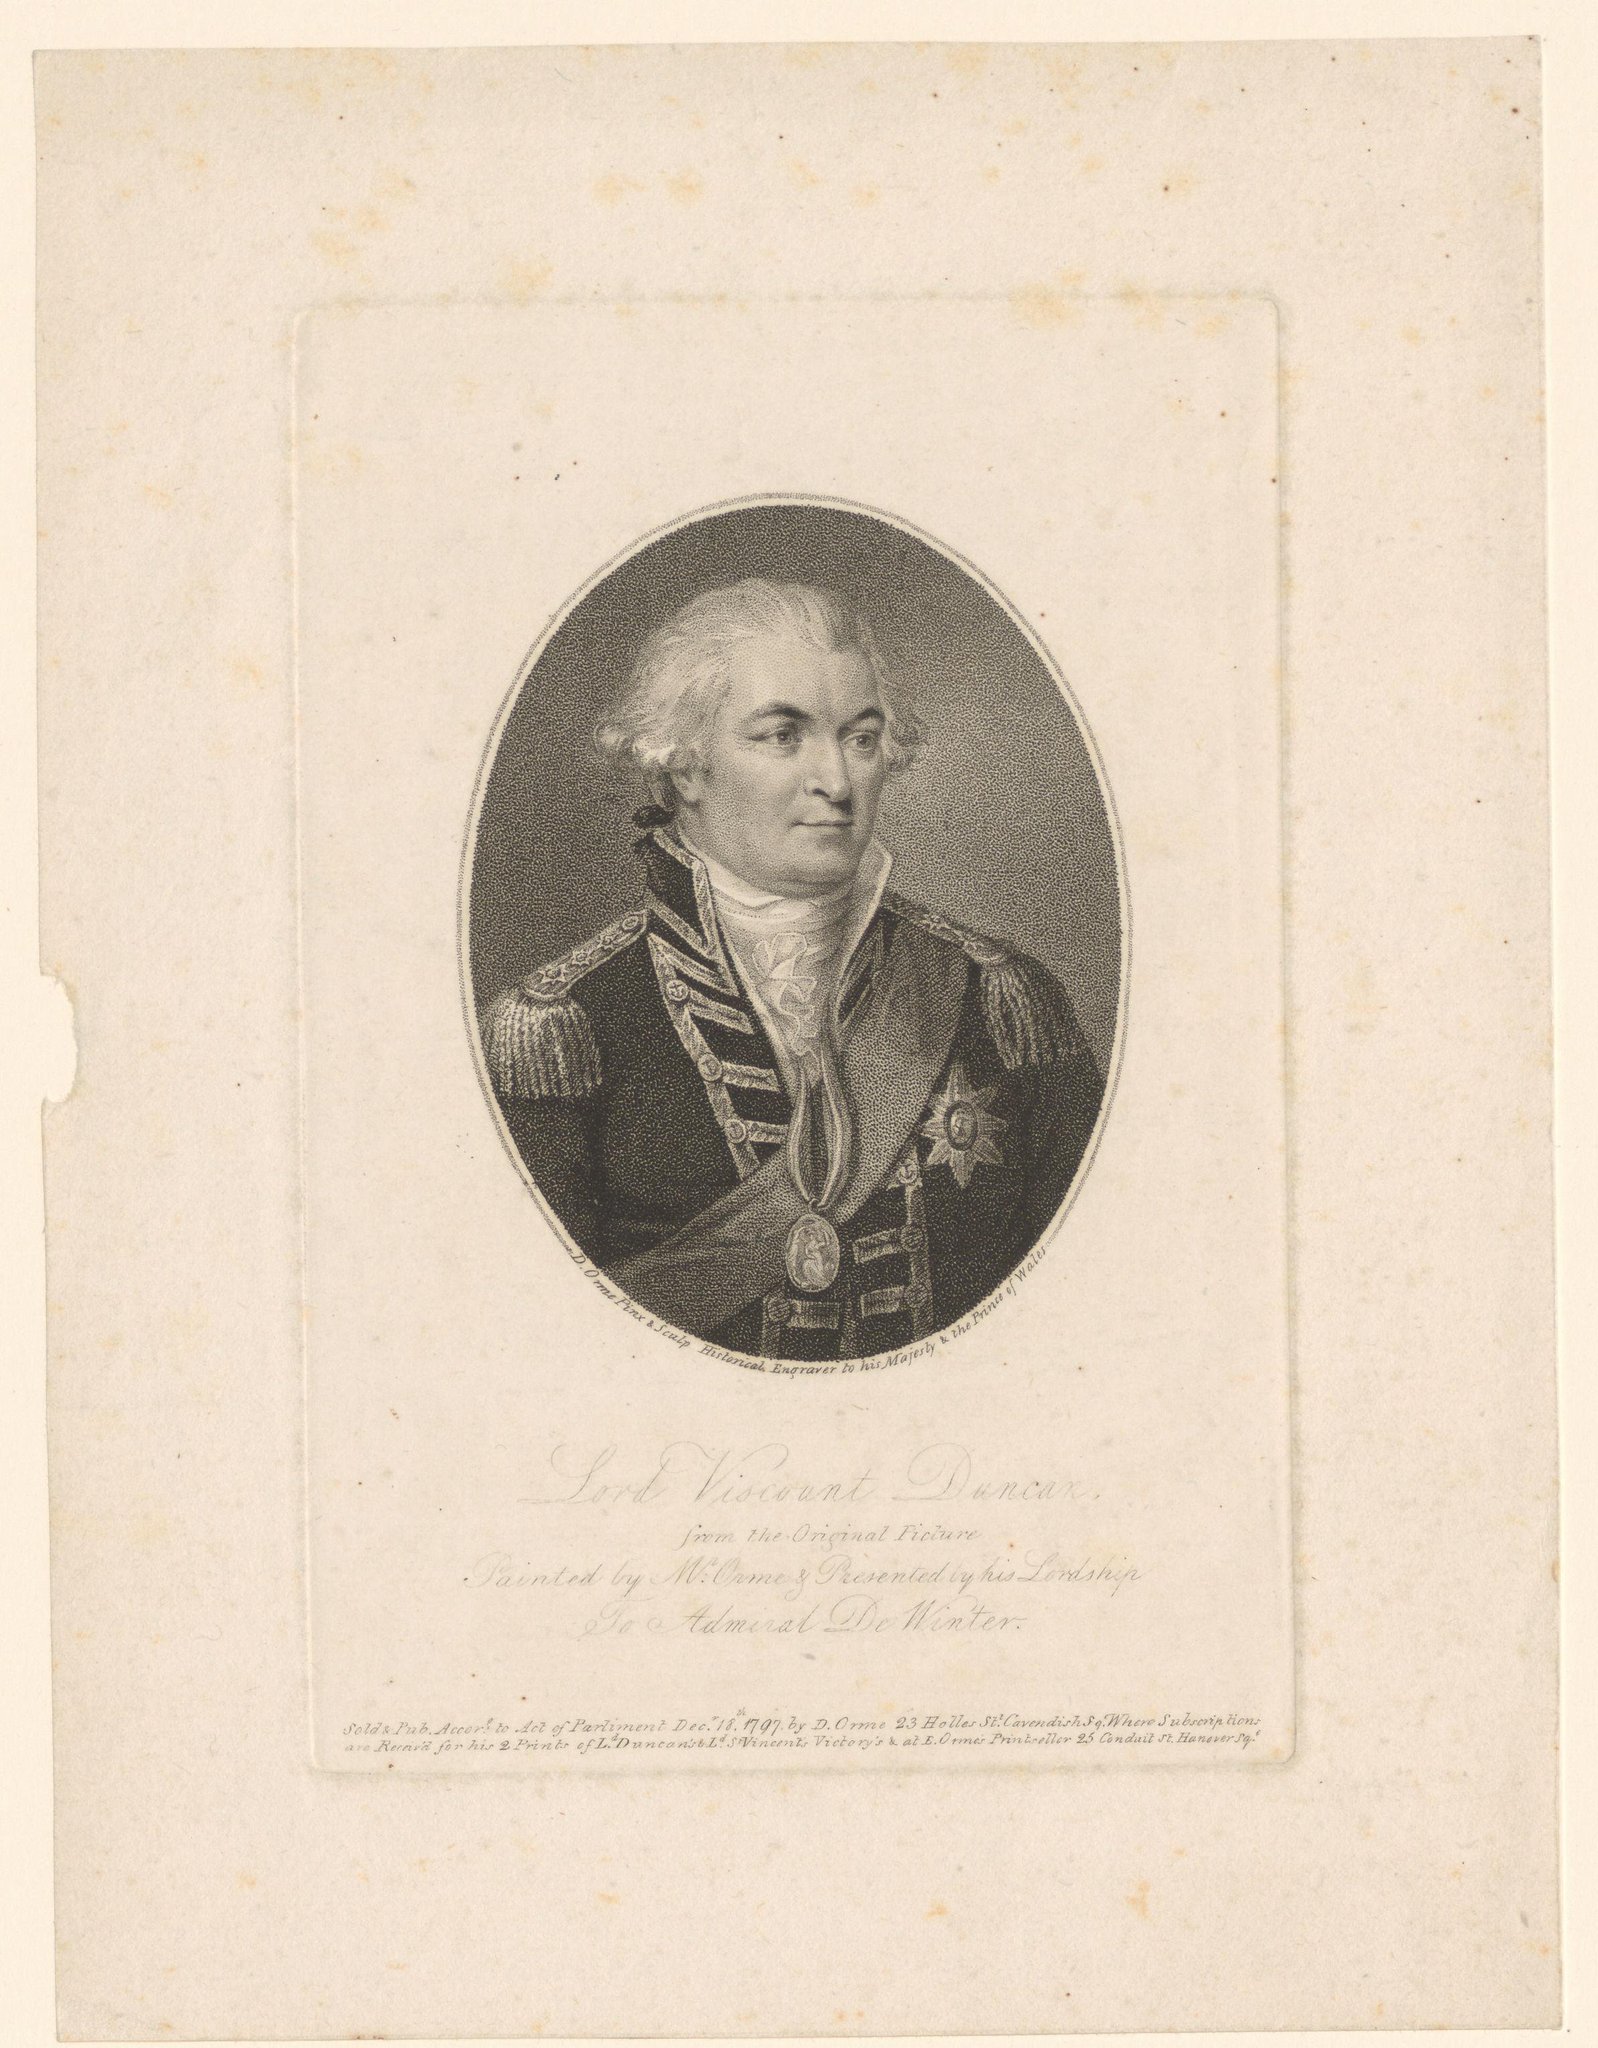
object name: print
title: Portret van Adam Duncan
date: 1712-1797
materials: paper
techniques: etching, engraving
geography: london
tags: adam duncan (burggraaf van duncan), paris, jan willem de winter, historical persons, officer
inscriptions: collector's mark: Lugt 2228